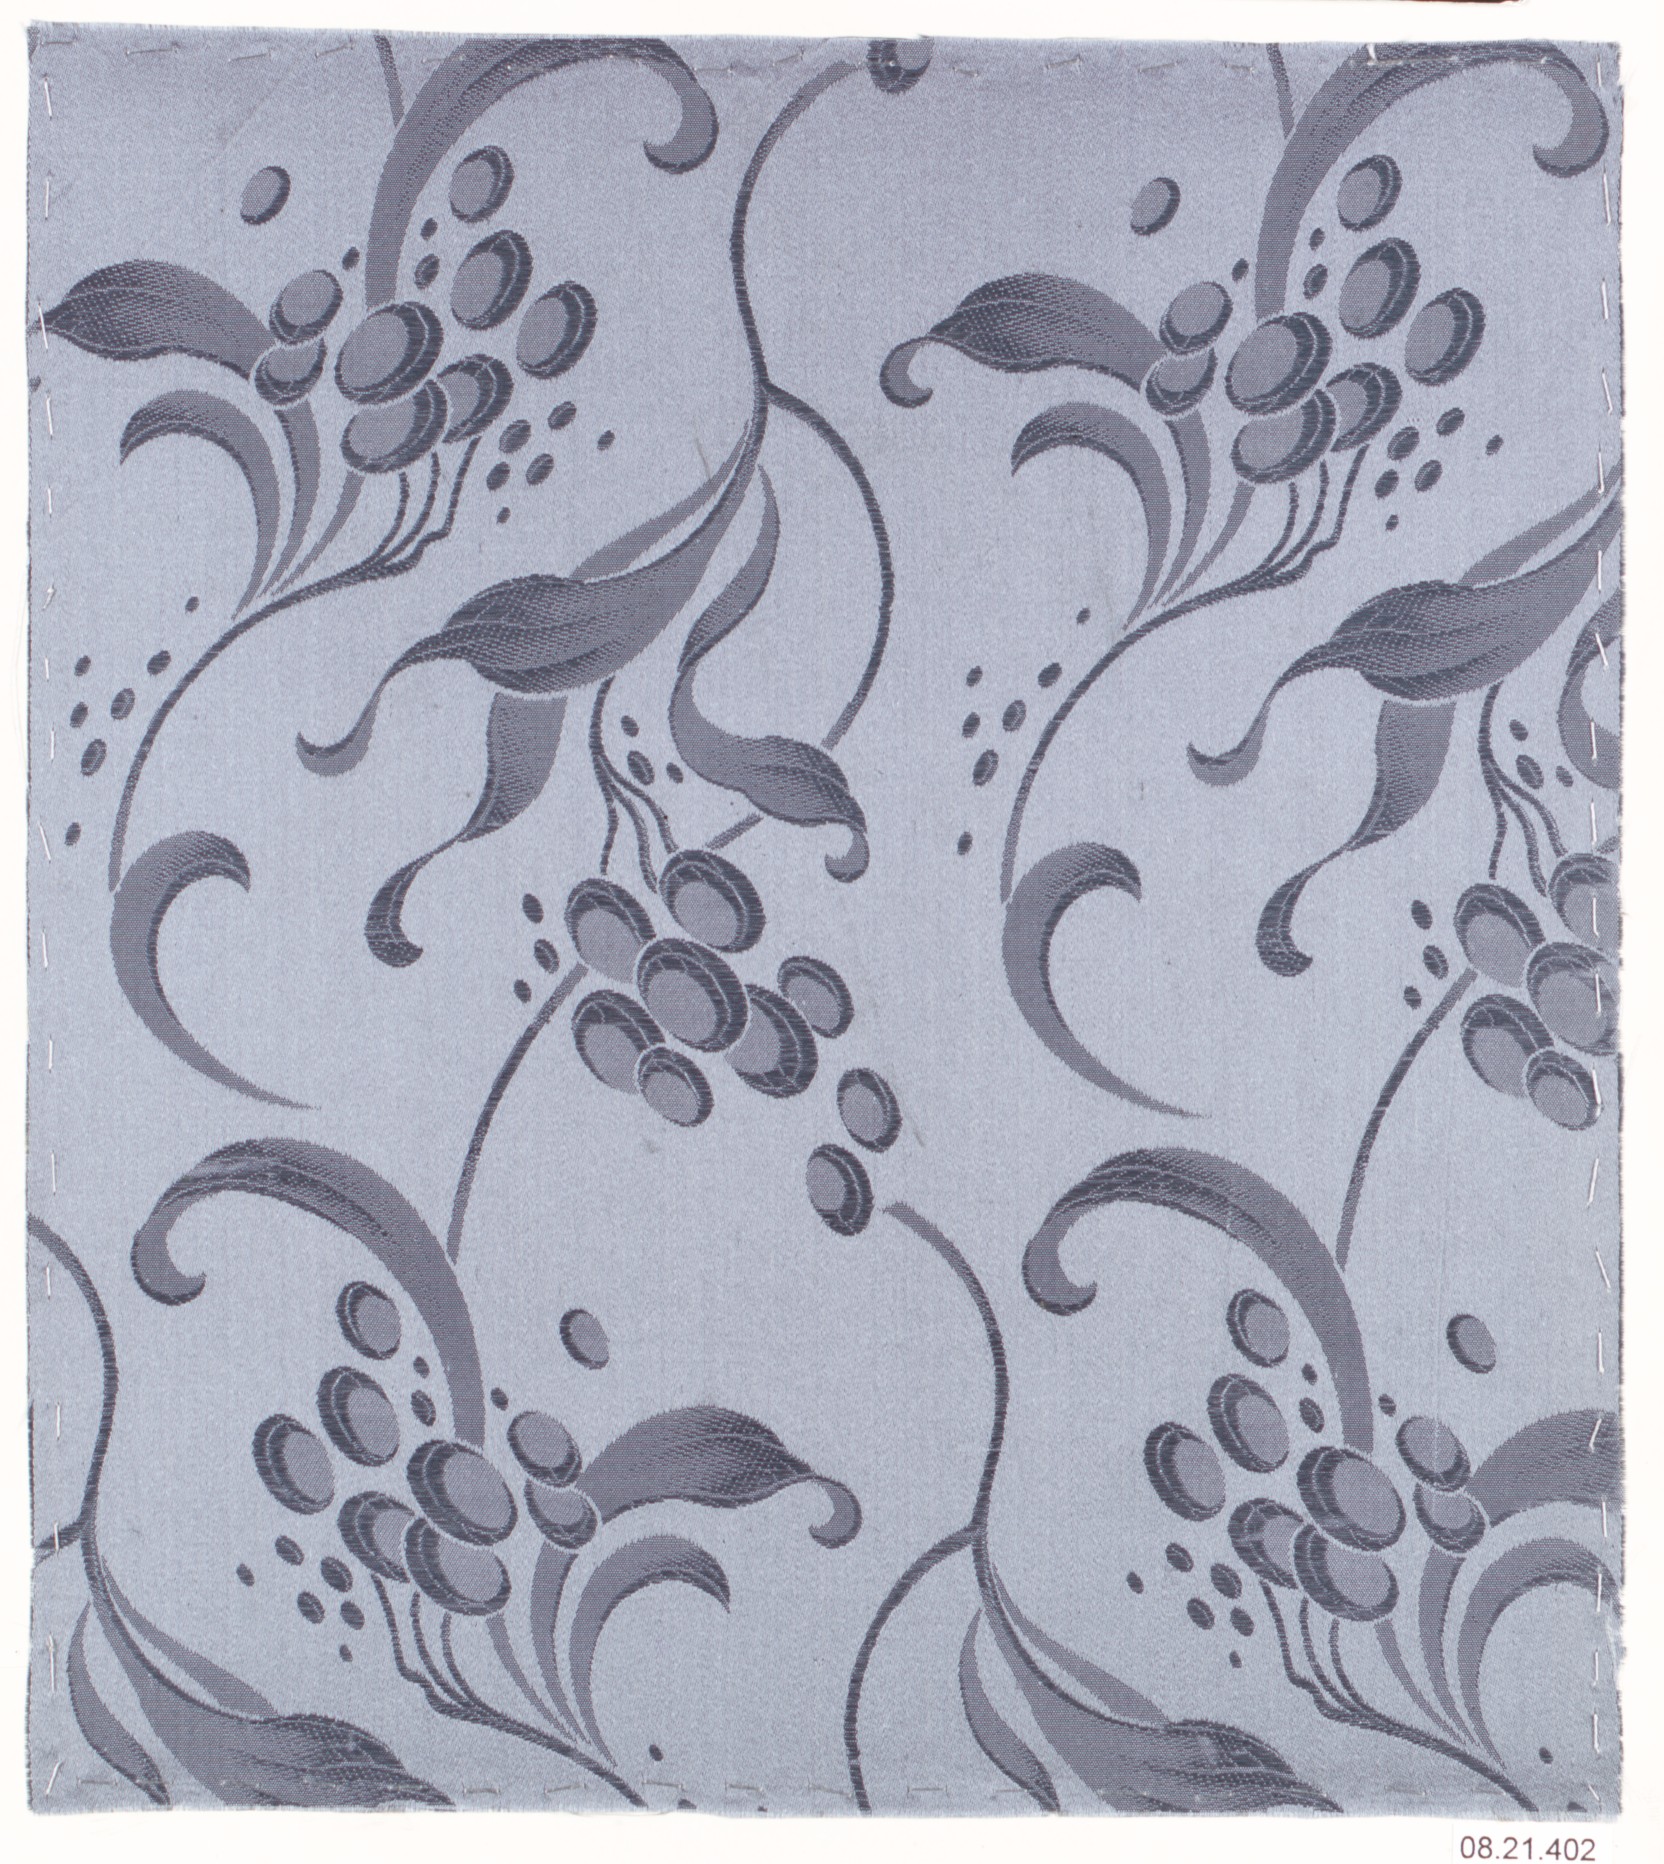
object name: textile sample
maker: Anonymous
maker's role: designer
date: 1900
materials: silk